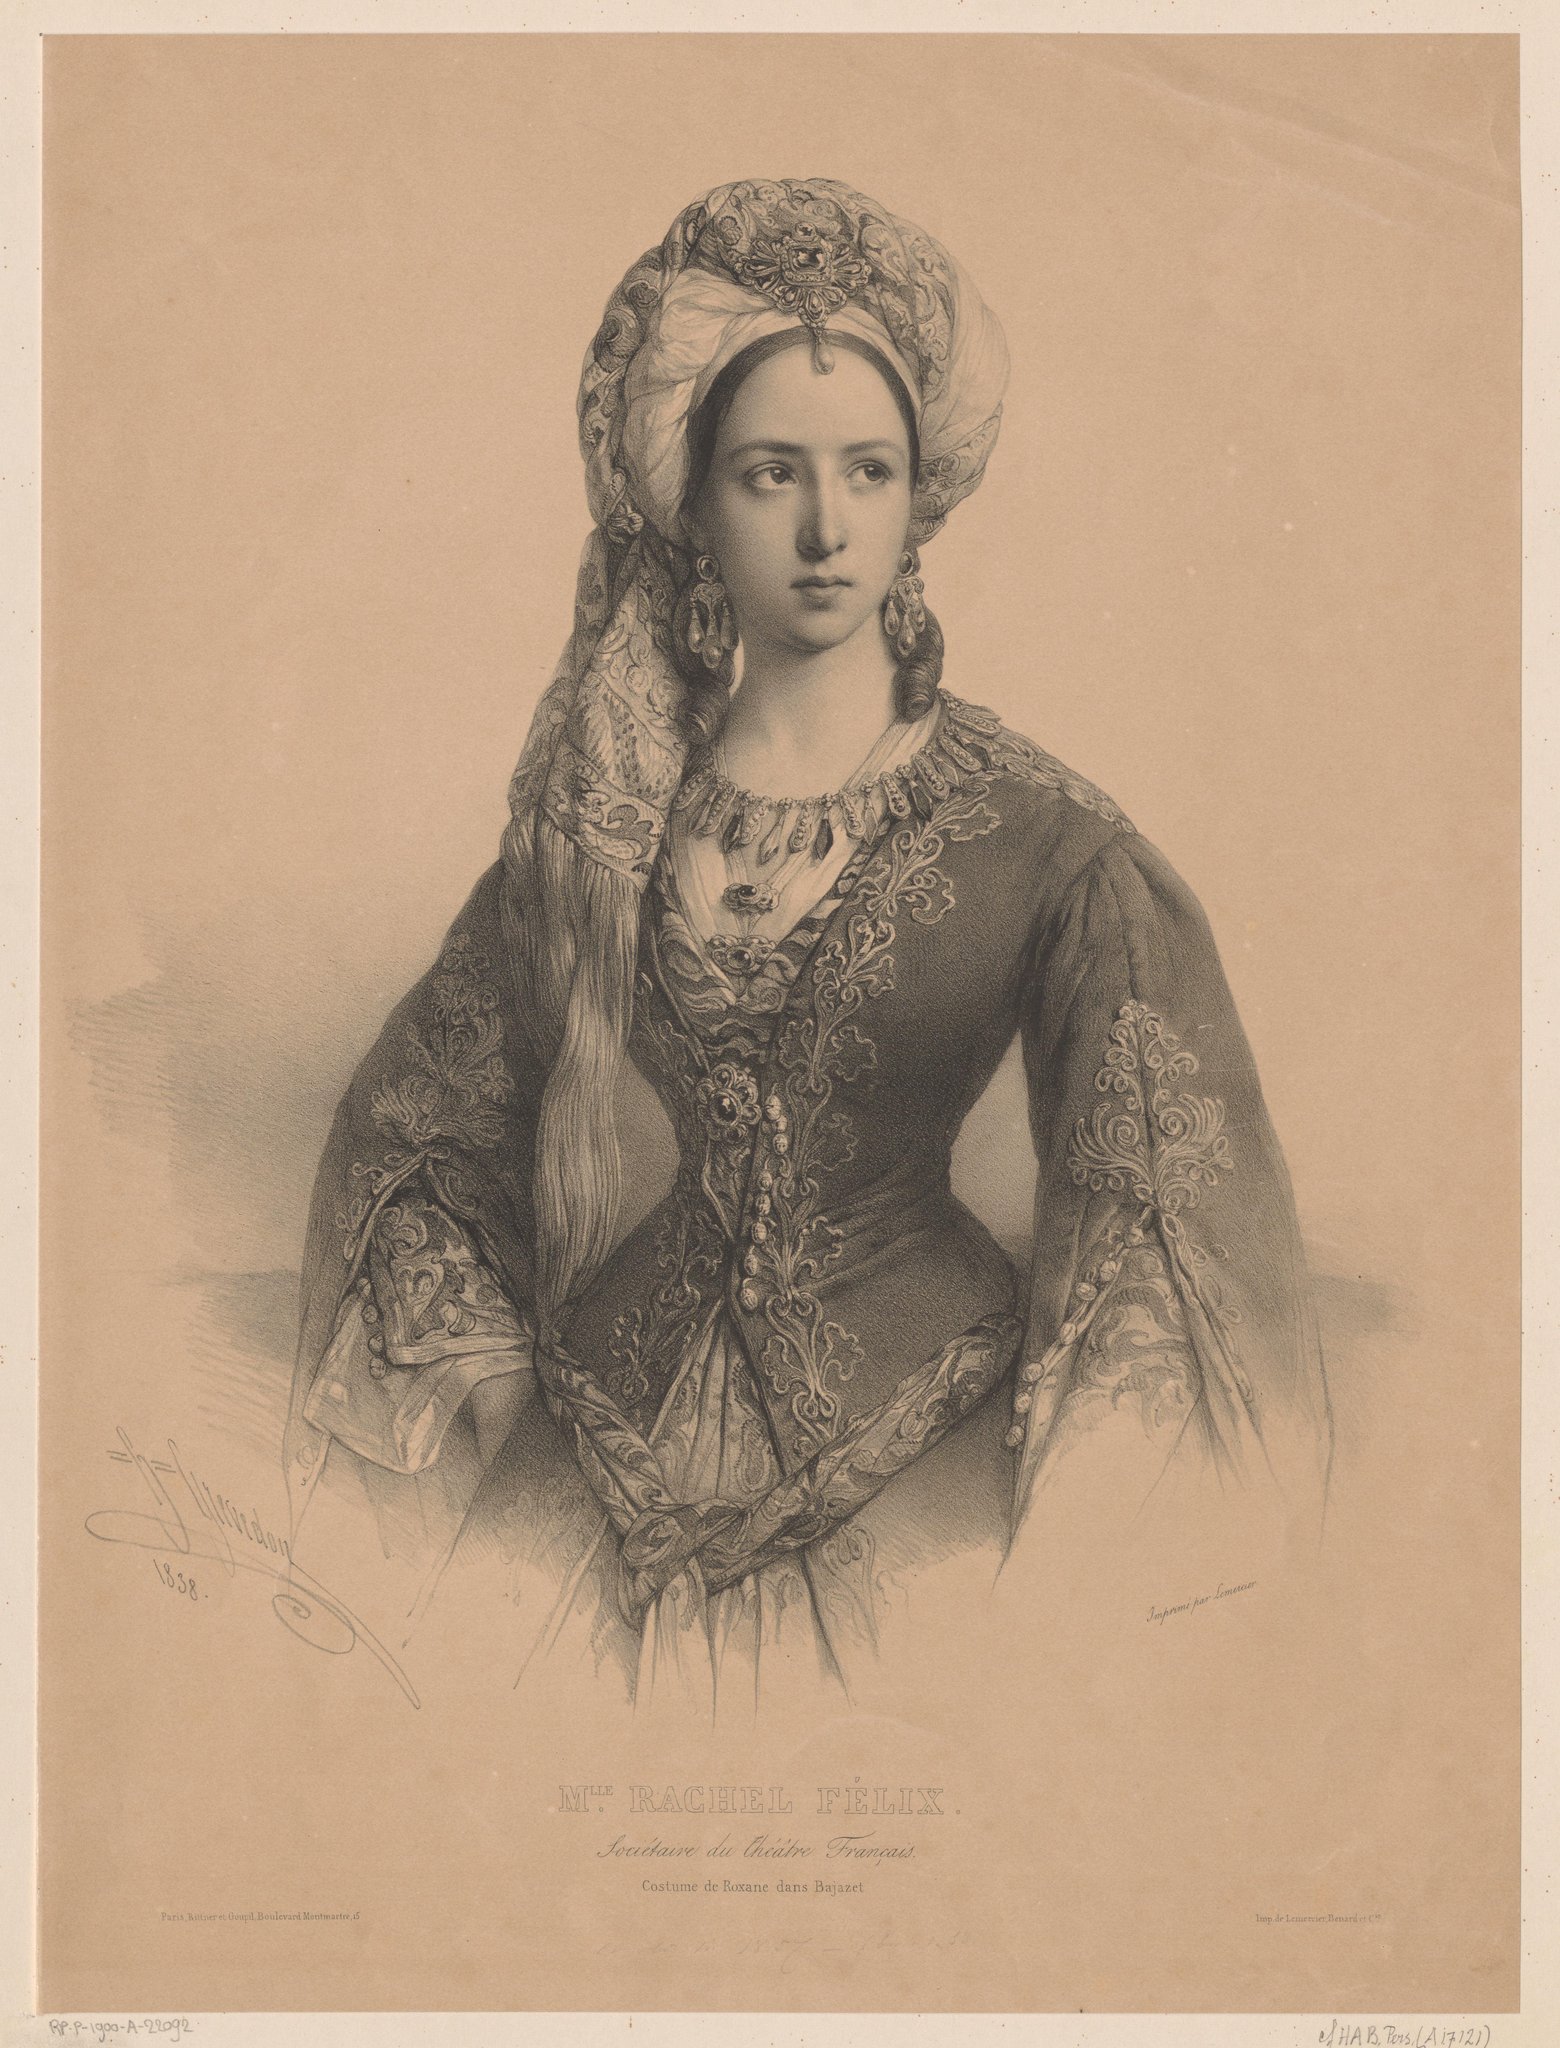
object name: print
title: Portret van Elizabeth-Rachel Félix als Roxane in de tragedie Bajazet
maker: henri grévedon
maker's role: painter, print maker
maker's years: 1776-1860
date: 1838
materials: paper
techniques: lithograph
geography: paris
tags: historical persons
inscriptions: collector's mark: Lugt 2228